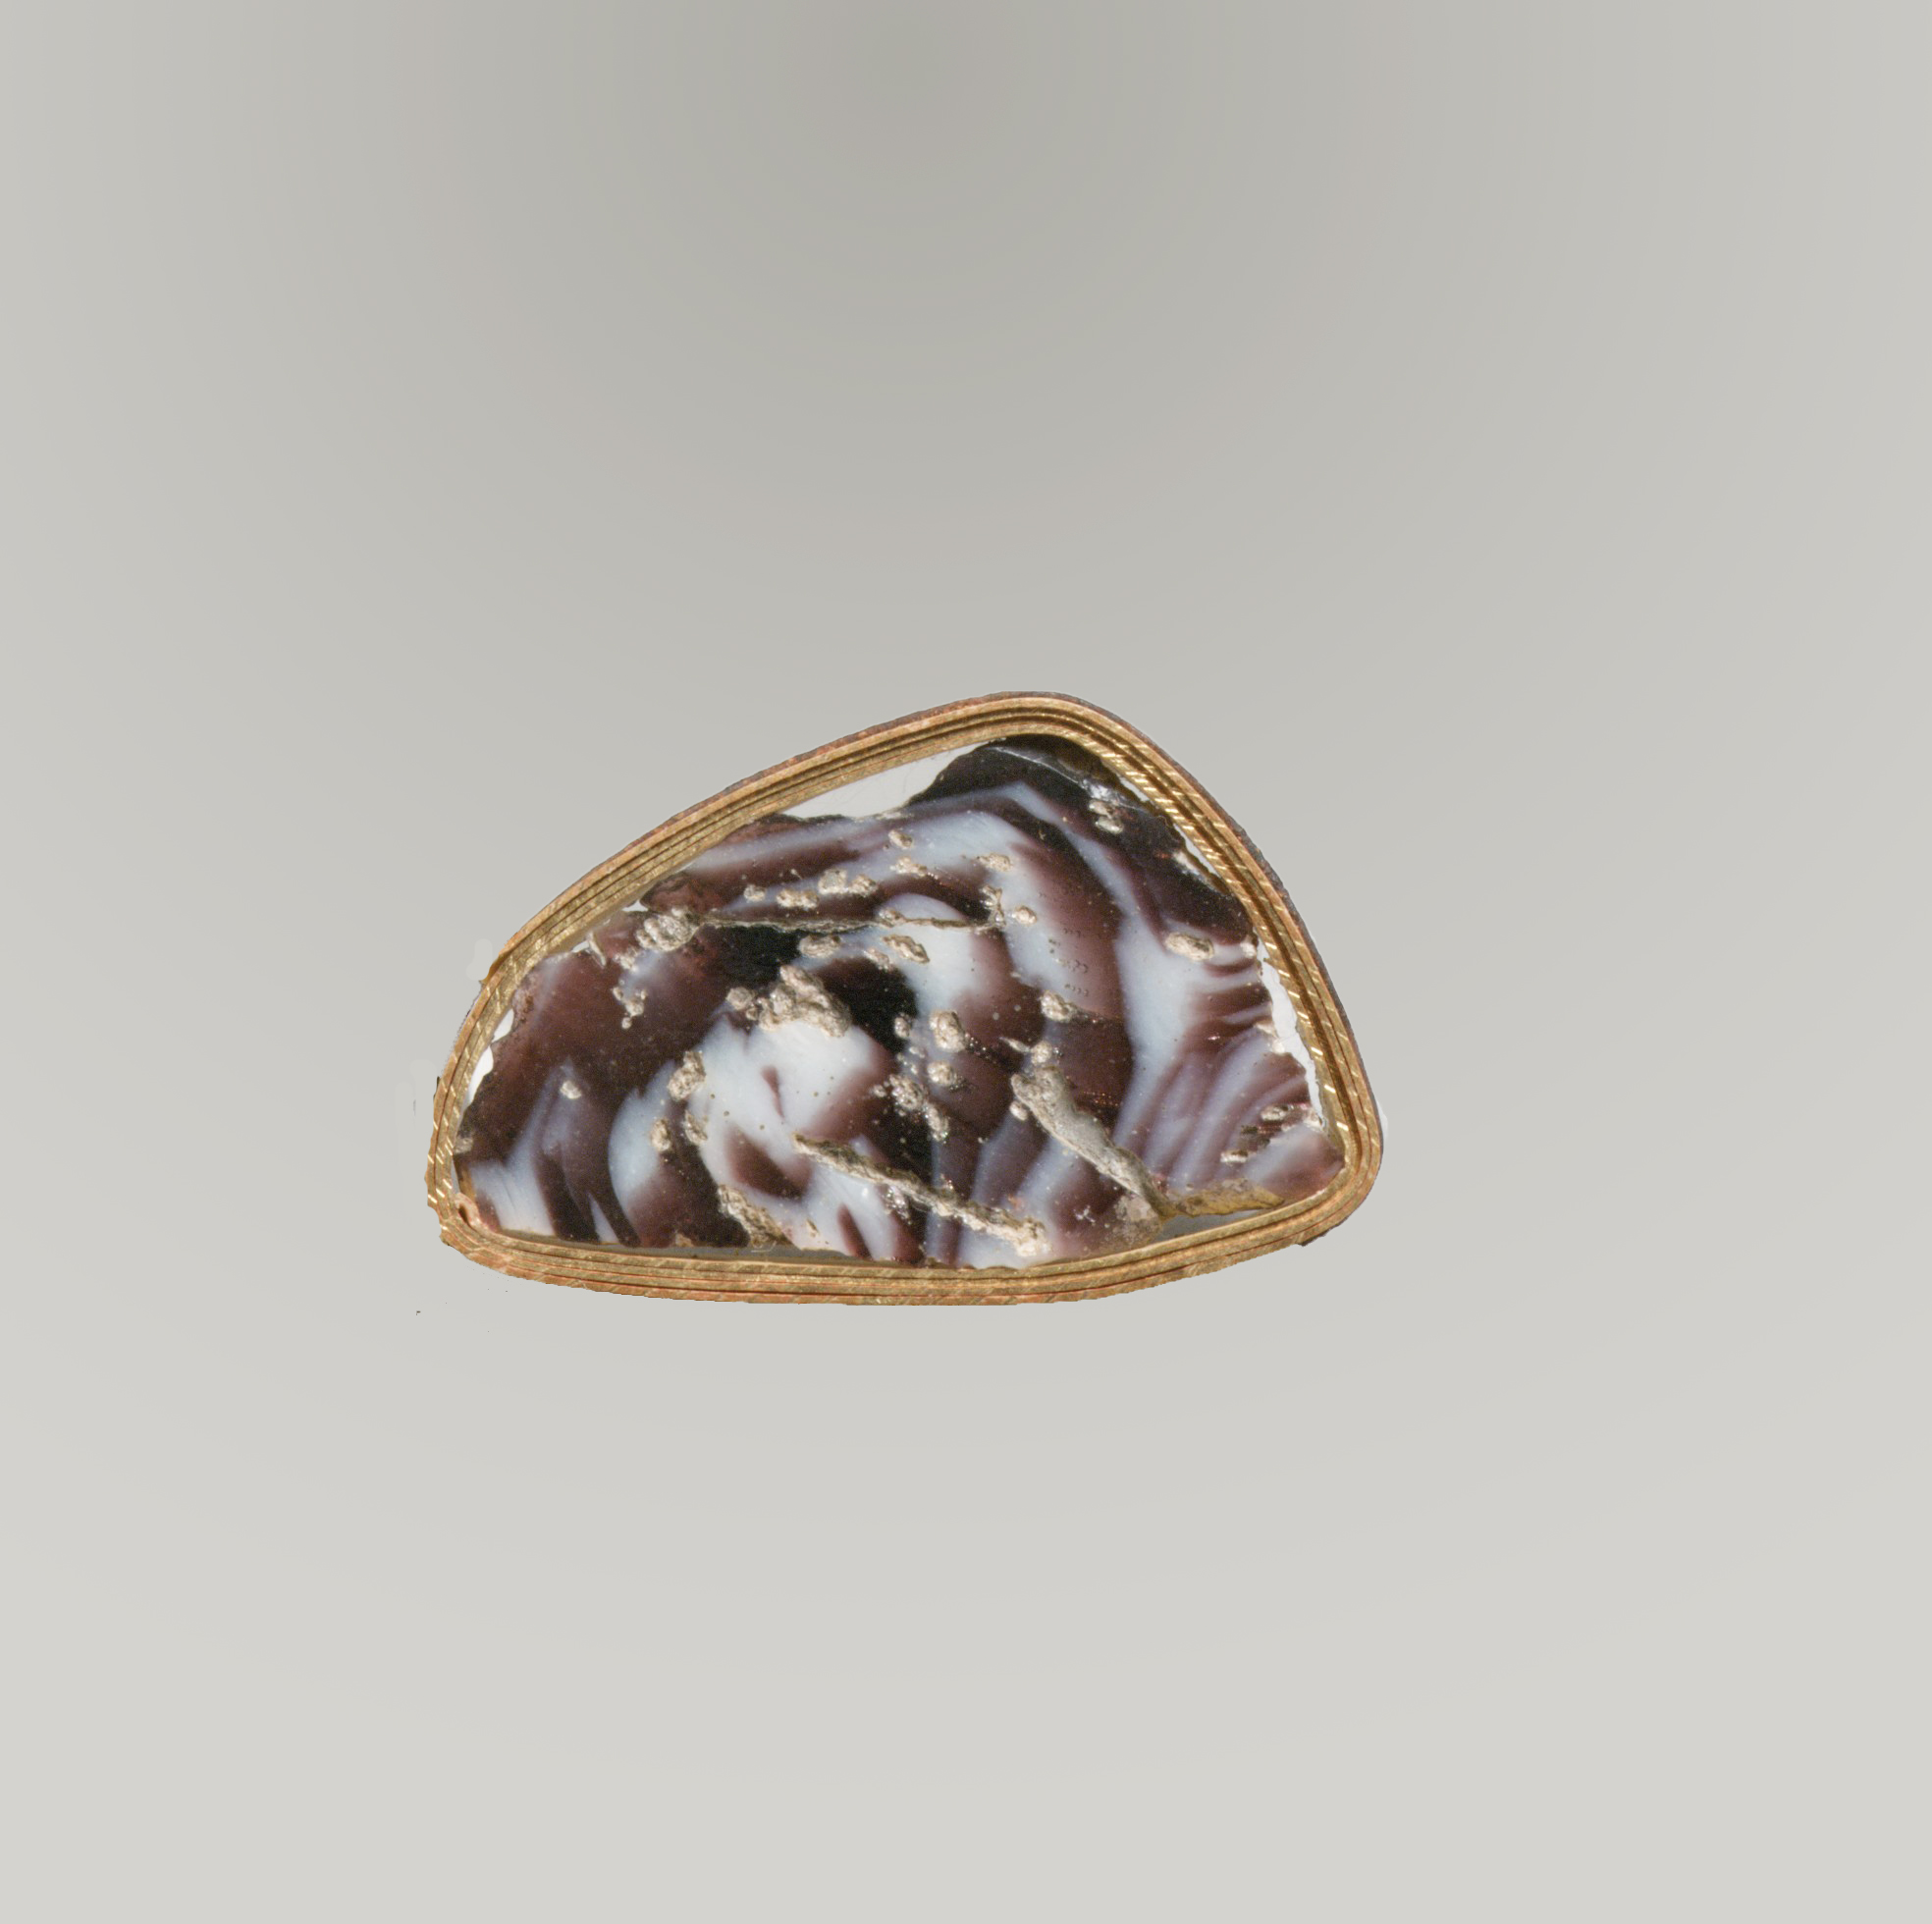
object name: fragment, mosaic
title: Glass mosaic inlay fragment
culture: roman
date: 34 BCE-33 CE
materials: glass